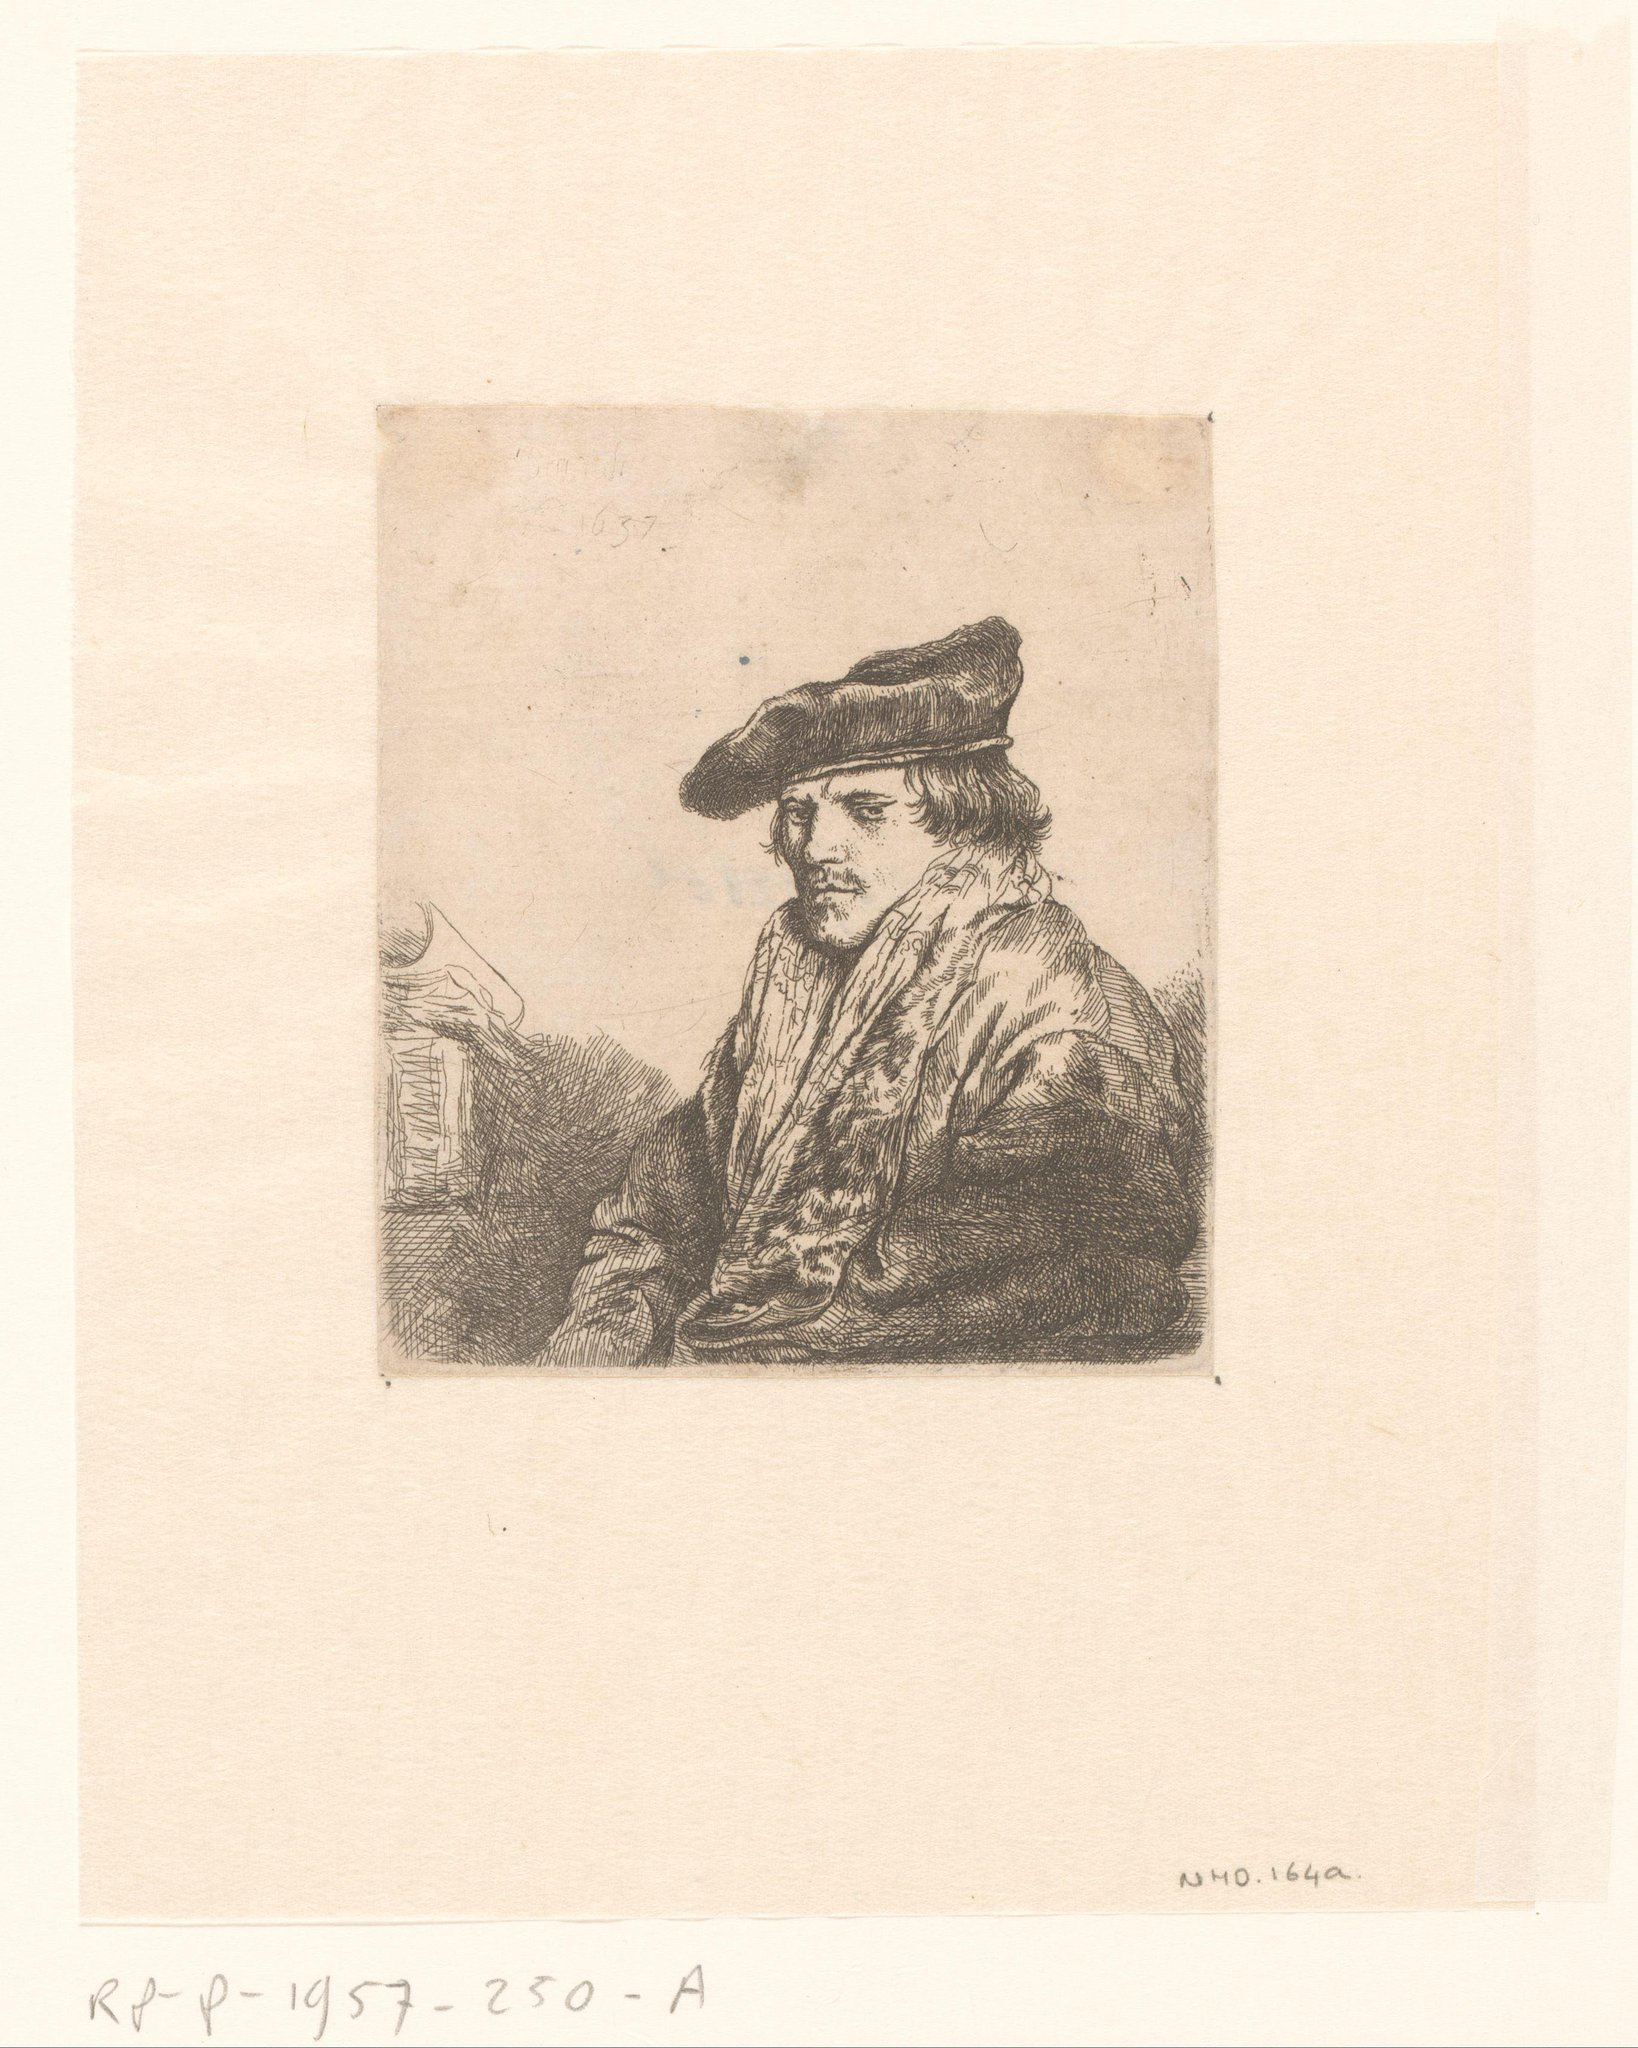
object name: print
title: Young man in a velvet cap (Petrus Sylvius?)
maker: james bretherton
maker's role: print maker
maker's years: 1750-1781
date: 1760-1781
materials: paper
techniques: etching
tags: youth, adolescent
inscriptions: collector's mark: Lugt 2760, collector's mark: Lugt 2228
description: Mogelijk een portret van Petrus Johannes Sylvius.